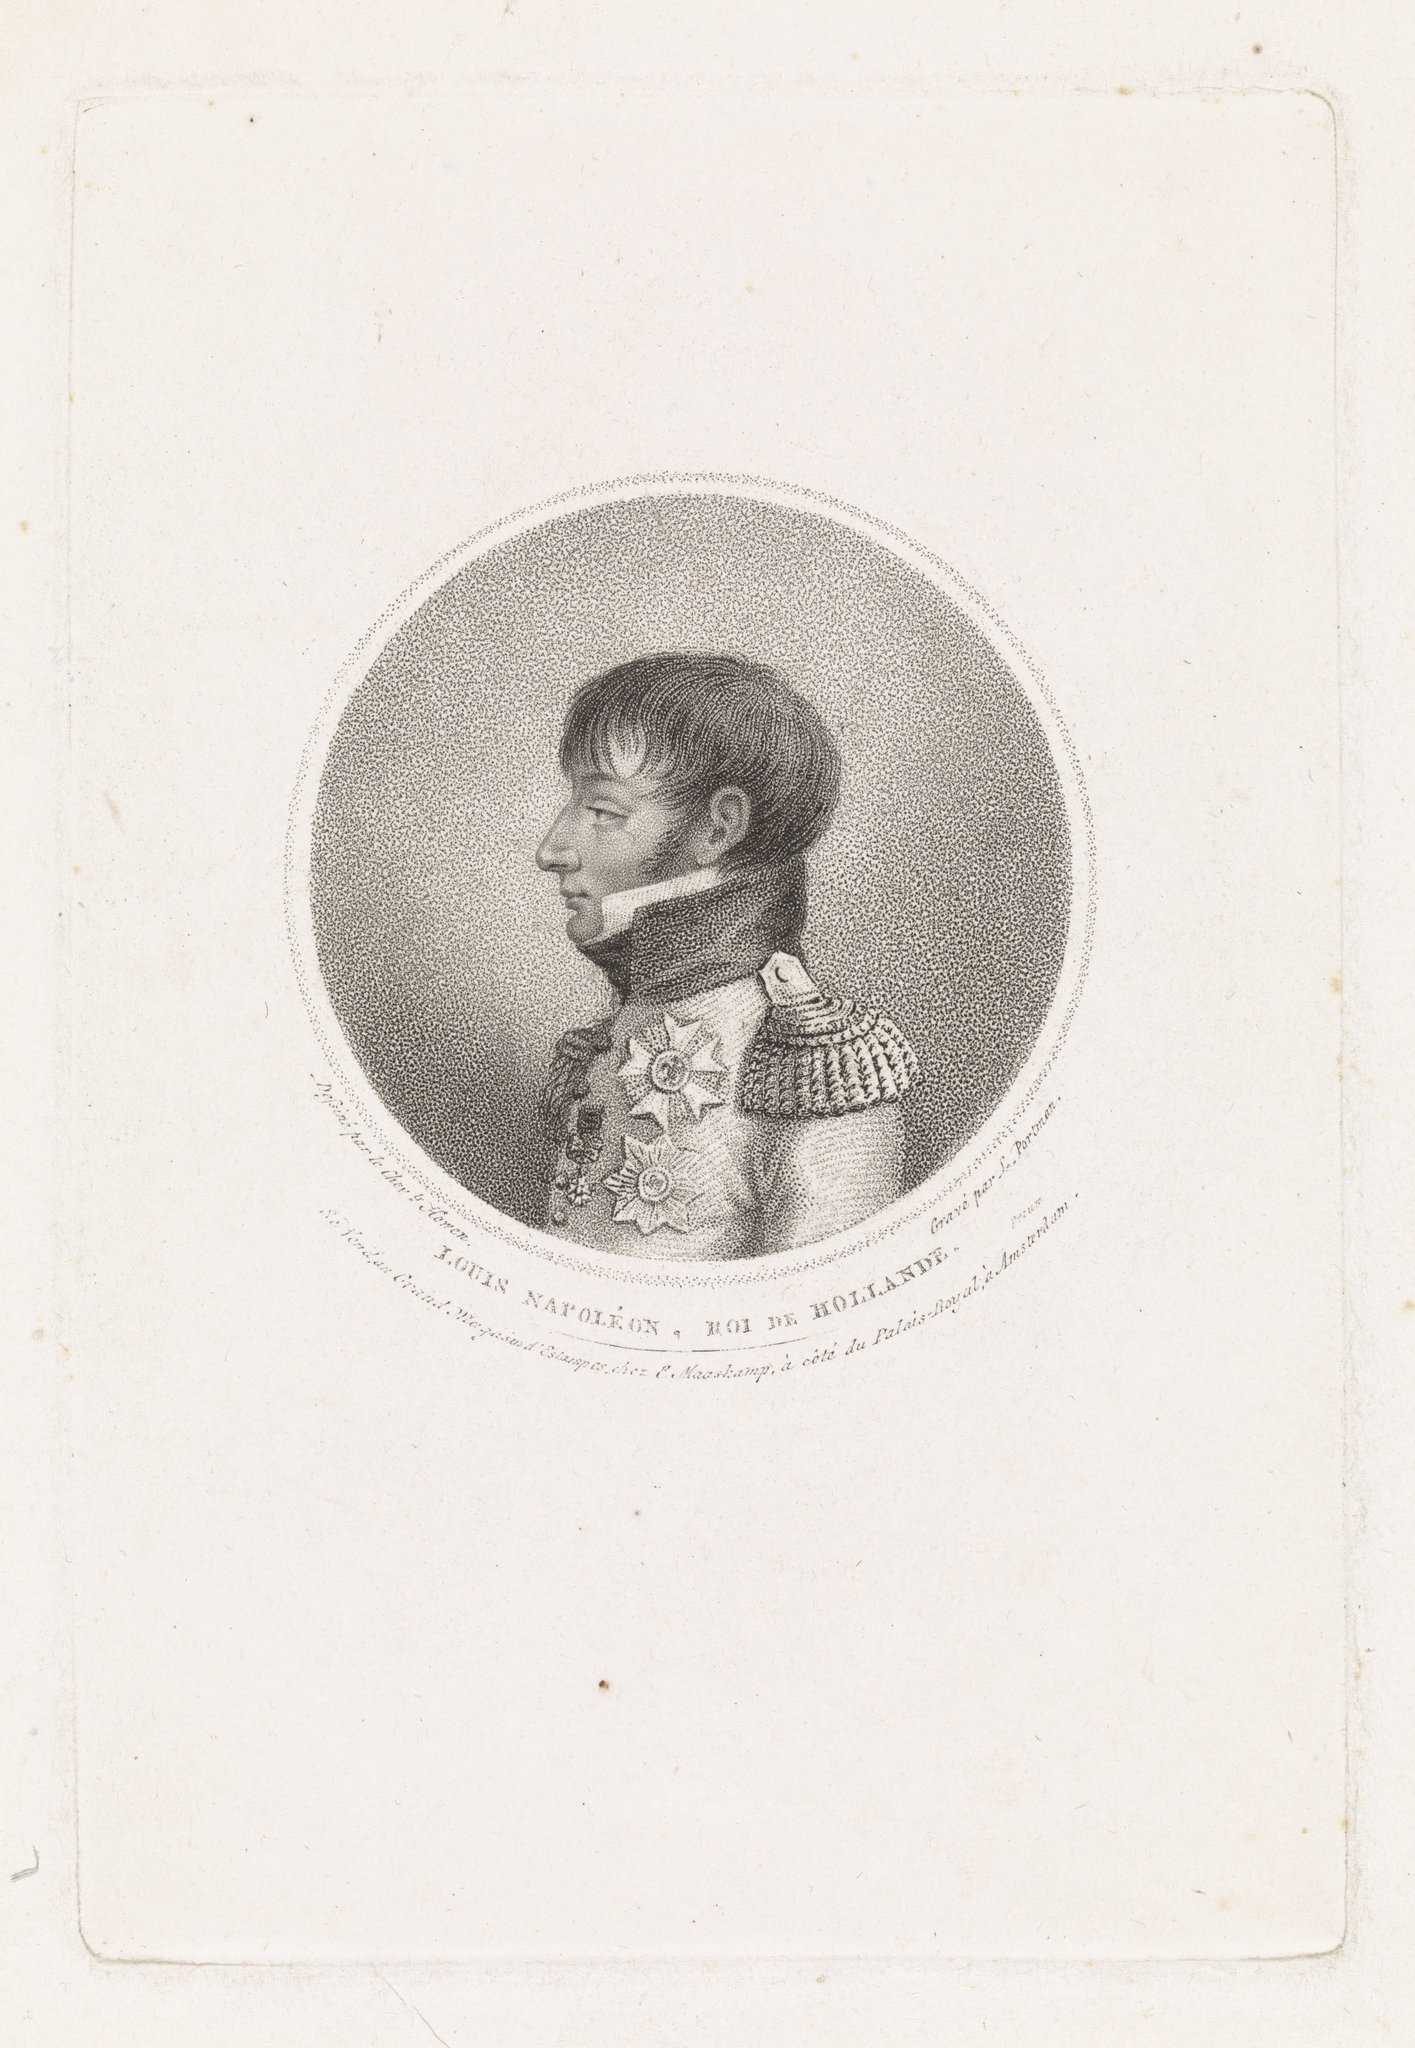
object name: print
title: Portret van Lodewijk Napoleon Bonaparte, koning van Holland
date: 1809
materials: paper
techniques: stippled etching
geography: amsterdam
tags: louis napoleon (king of holland), knighthood order, holland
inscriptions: collector's mark: Lugt 2228